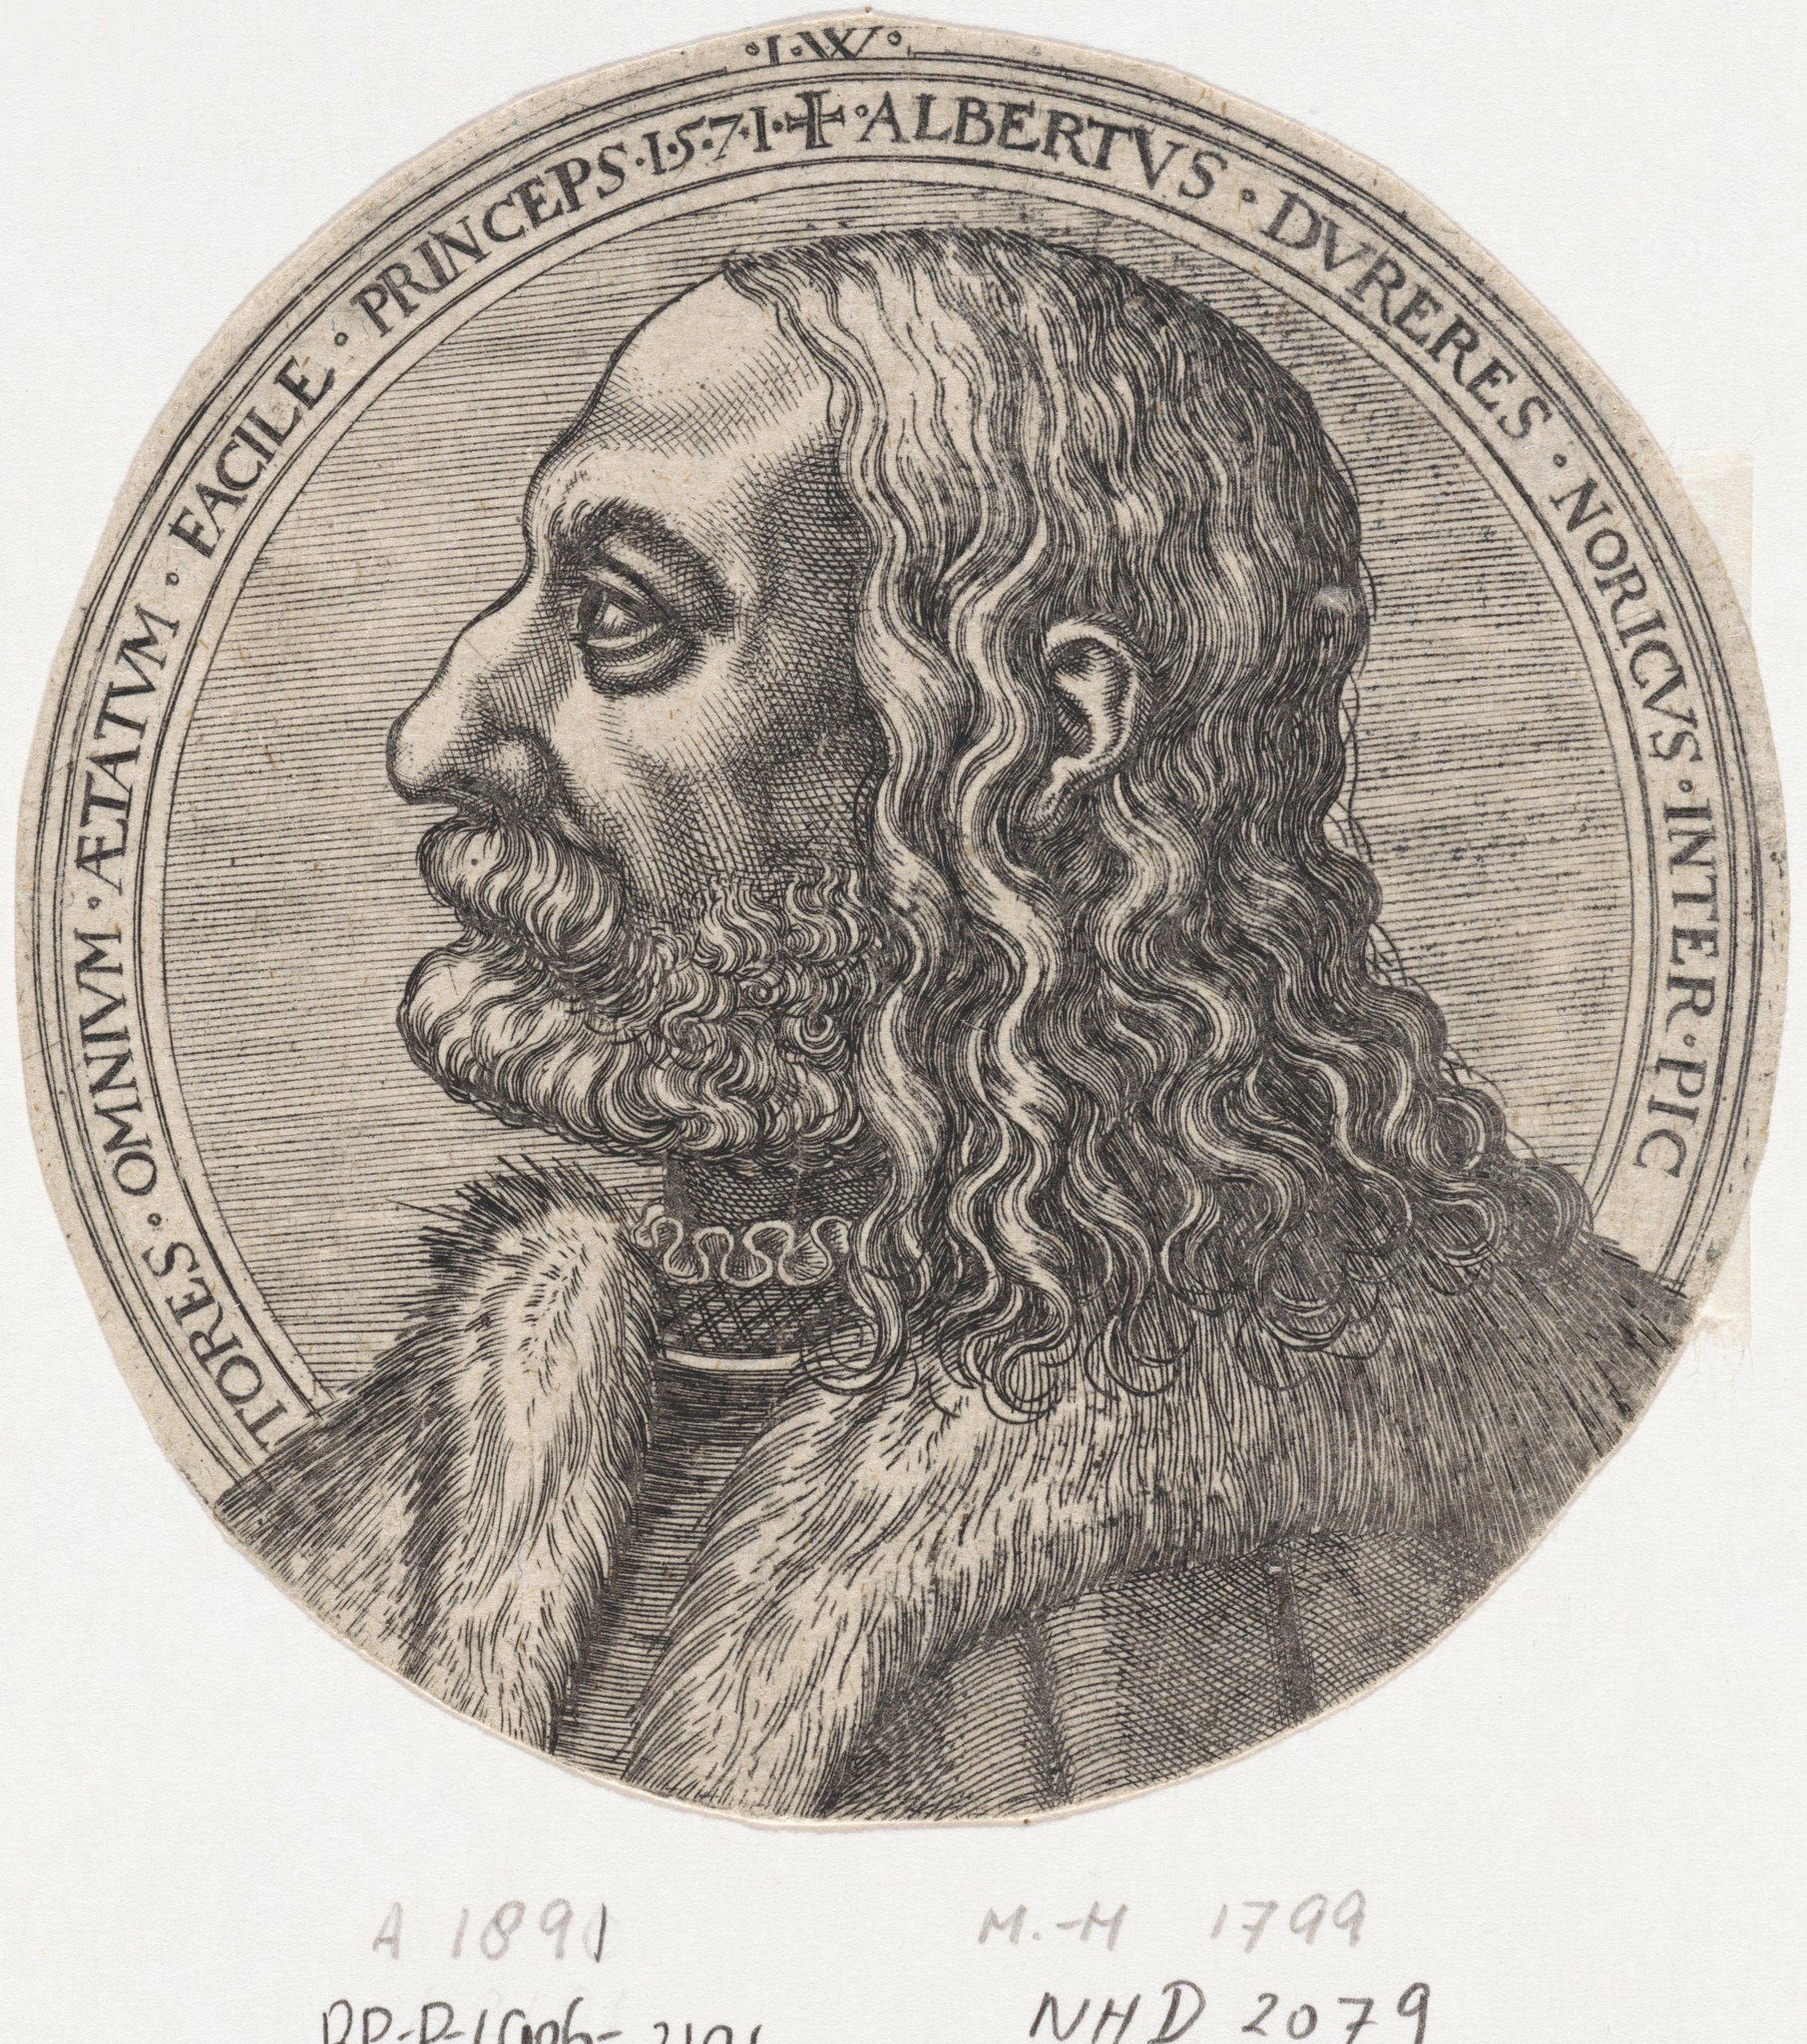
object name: print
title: Portret van Albrecht Dürer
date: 1571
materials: paper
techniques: engraving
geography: antwerp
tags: painter, print maker, draughtsman, albrecht dürer, portrait, self-portrait of graphic artist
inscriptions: collector's mark: Lugt 2228